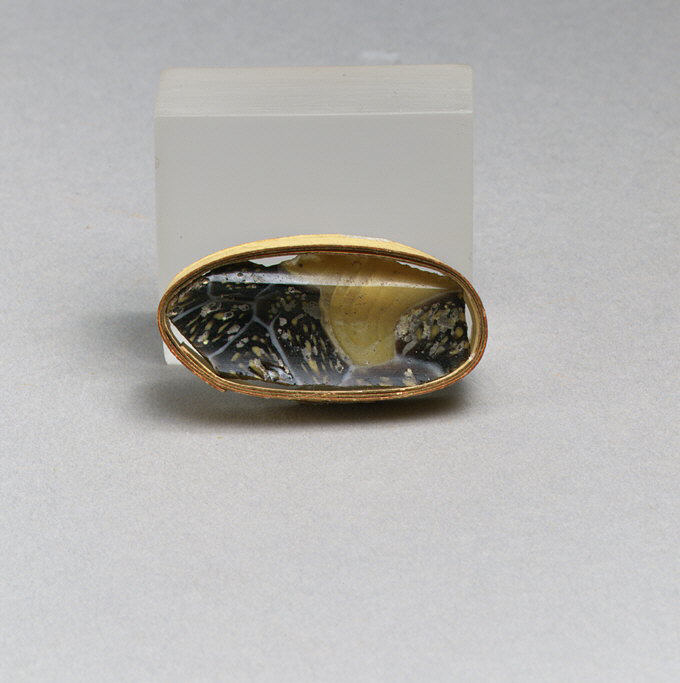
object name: fragment, mosaic bowl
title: Glass mosaic carinated bowl fragment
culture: roman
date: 34 BCE-33 CE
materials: glass